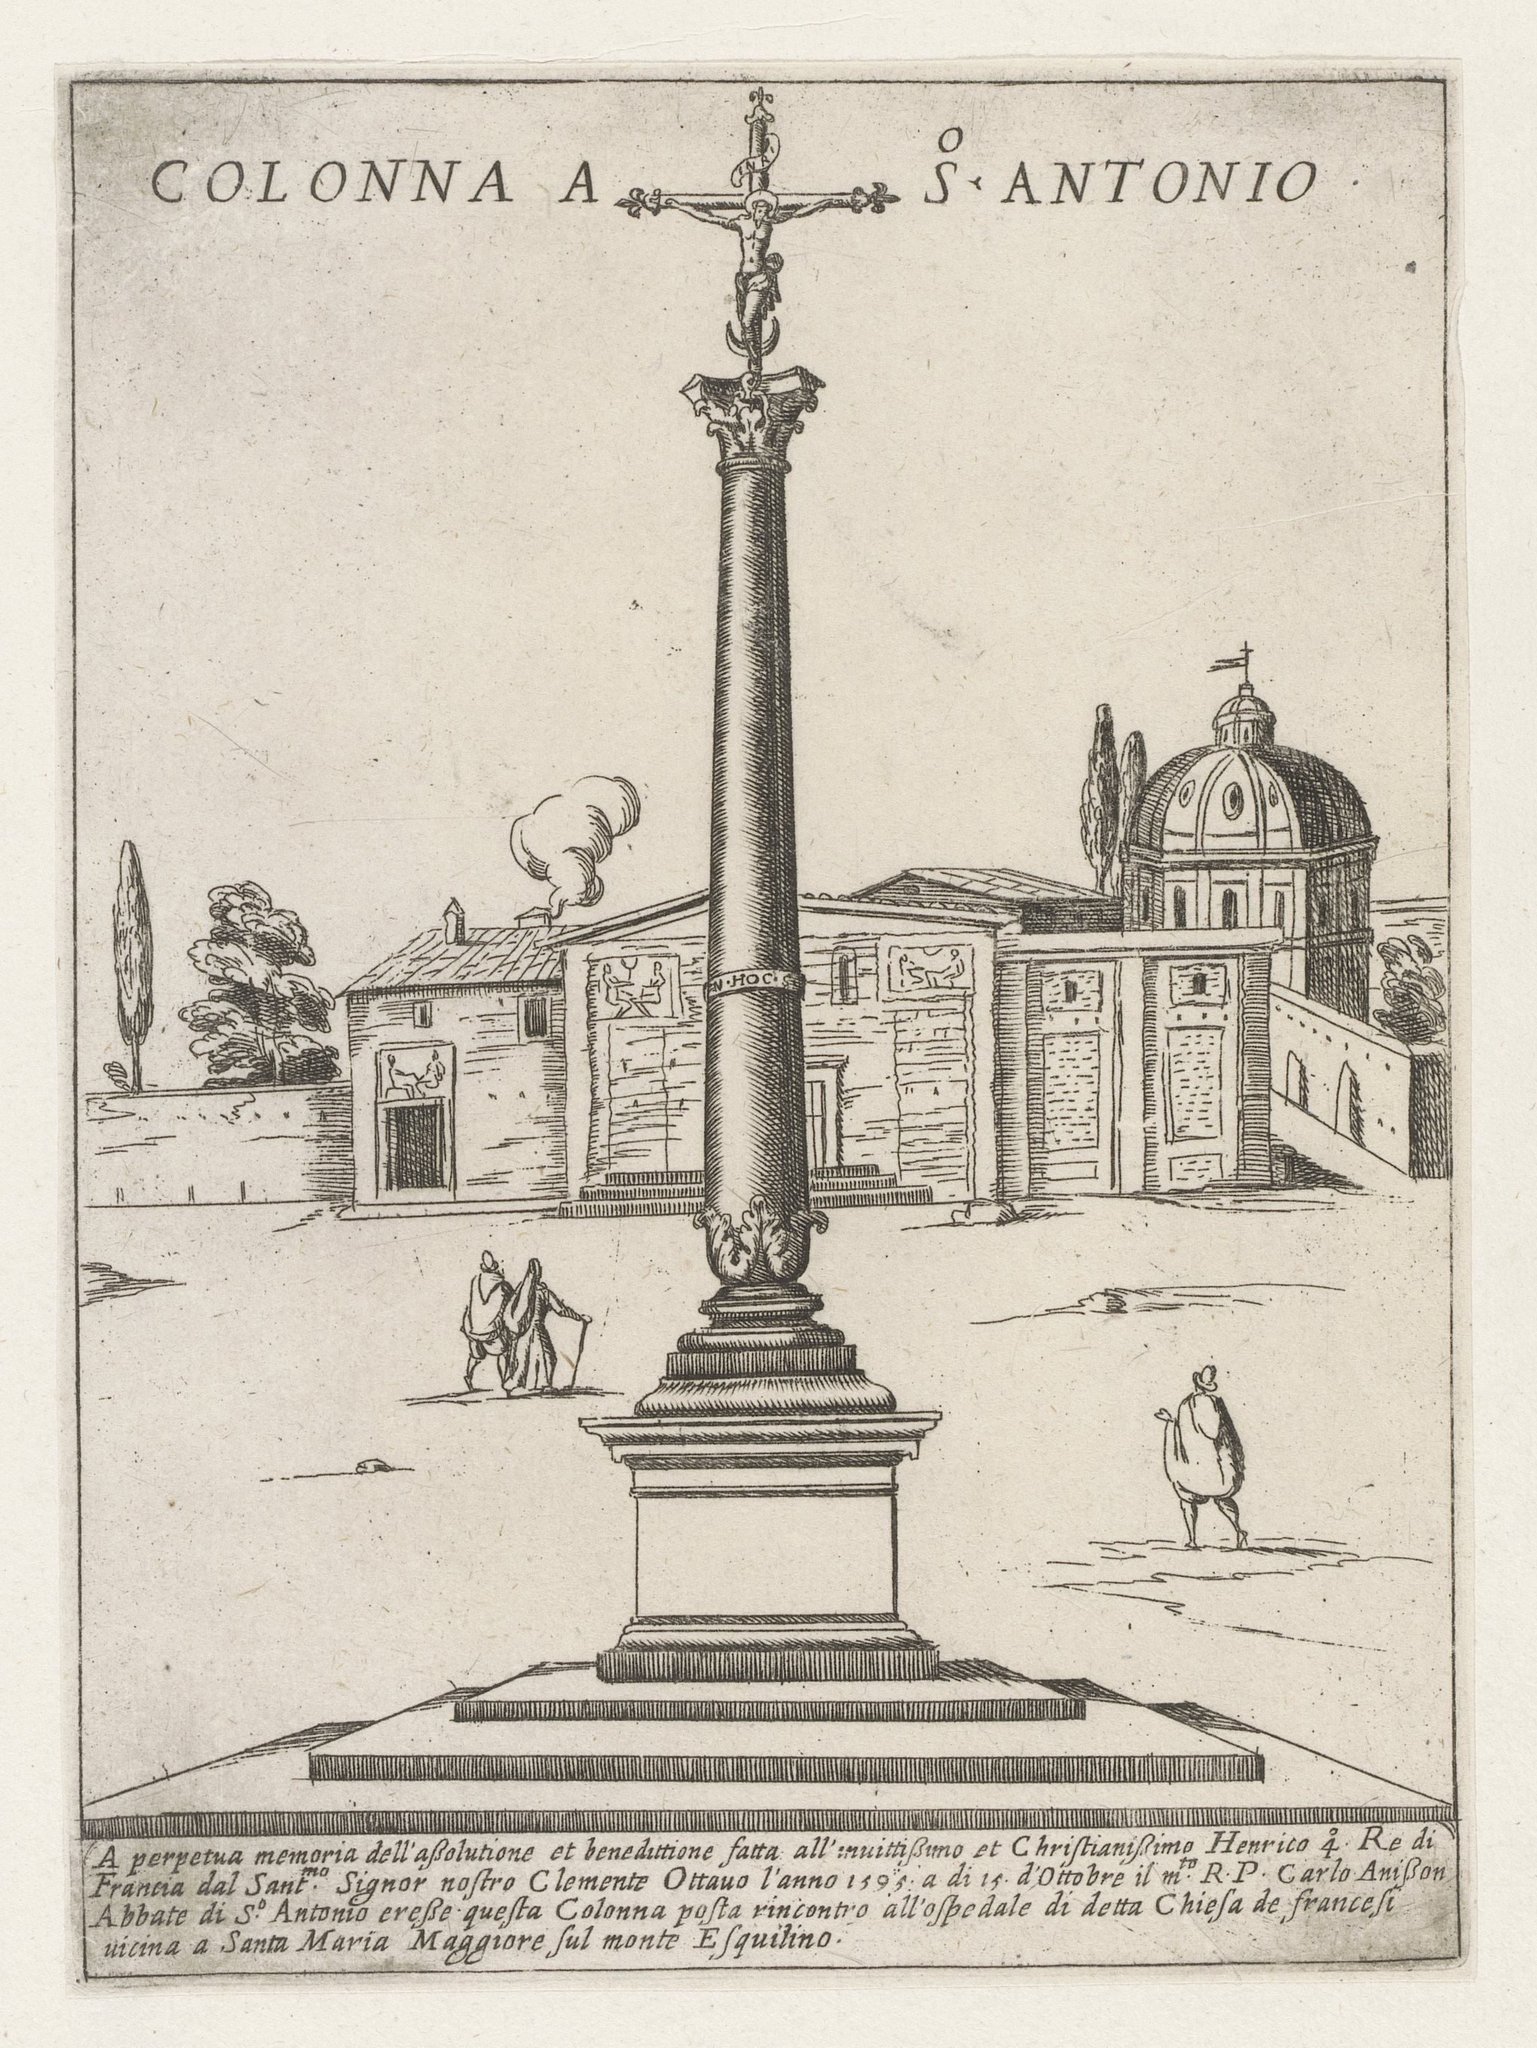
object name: print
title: Magesyn der Italiaense gebouwen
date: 1651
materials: paper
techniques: etching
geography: italy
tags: triumphal column with helical friezes, rome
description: Gezicht op een plein met een zuil voor een kerk te Rome. Bovenop de zuil een sculptuur van de gekruisigde Christus. Tekst in het Italiaans in de ondermarge. De prent maakt deel uit van een album.